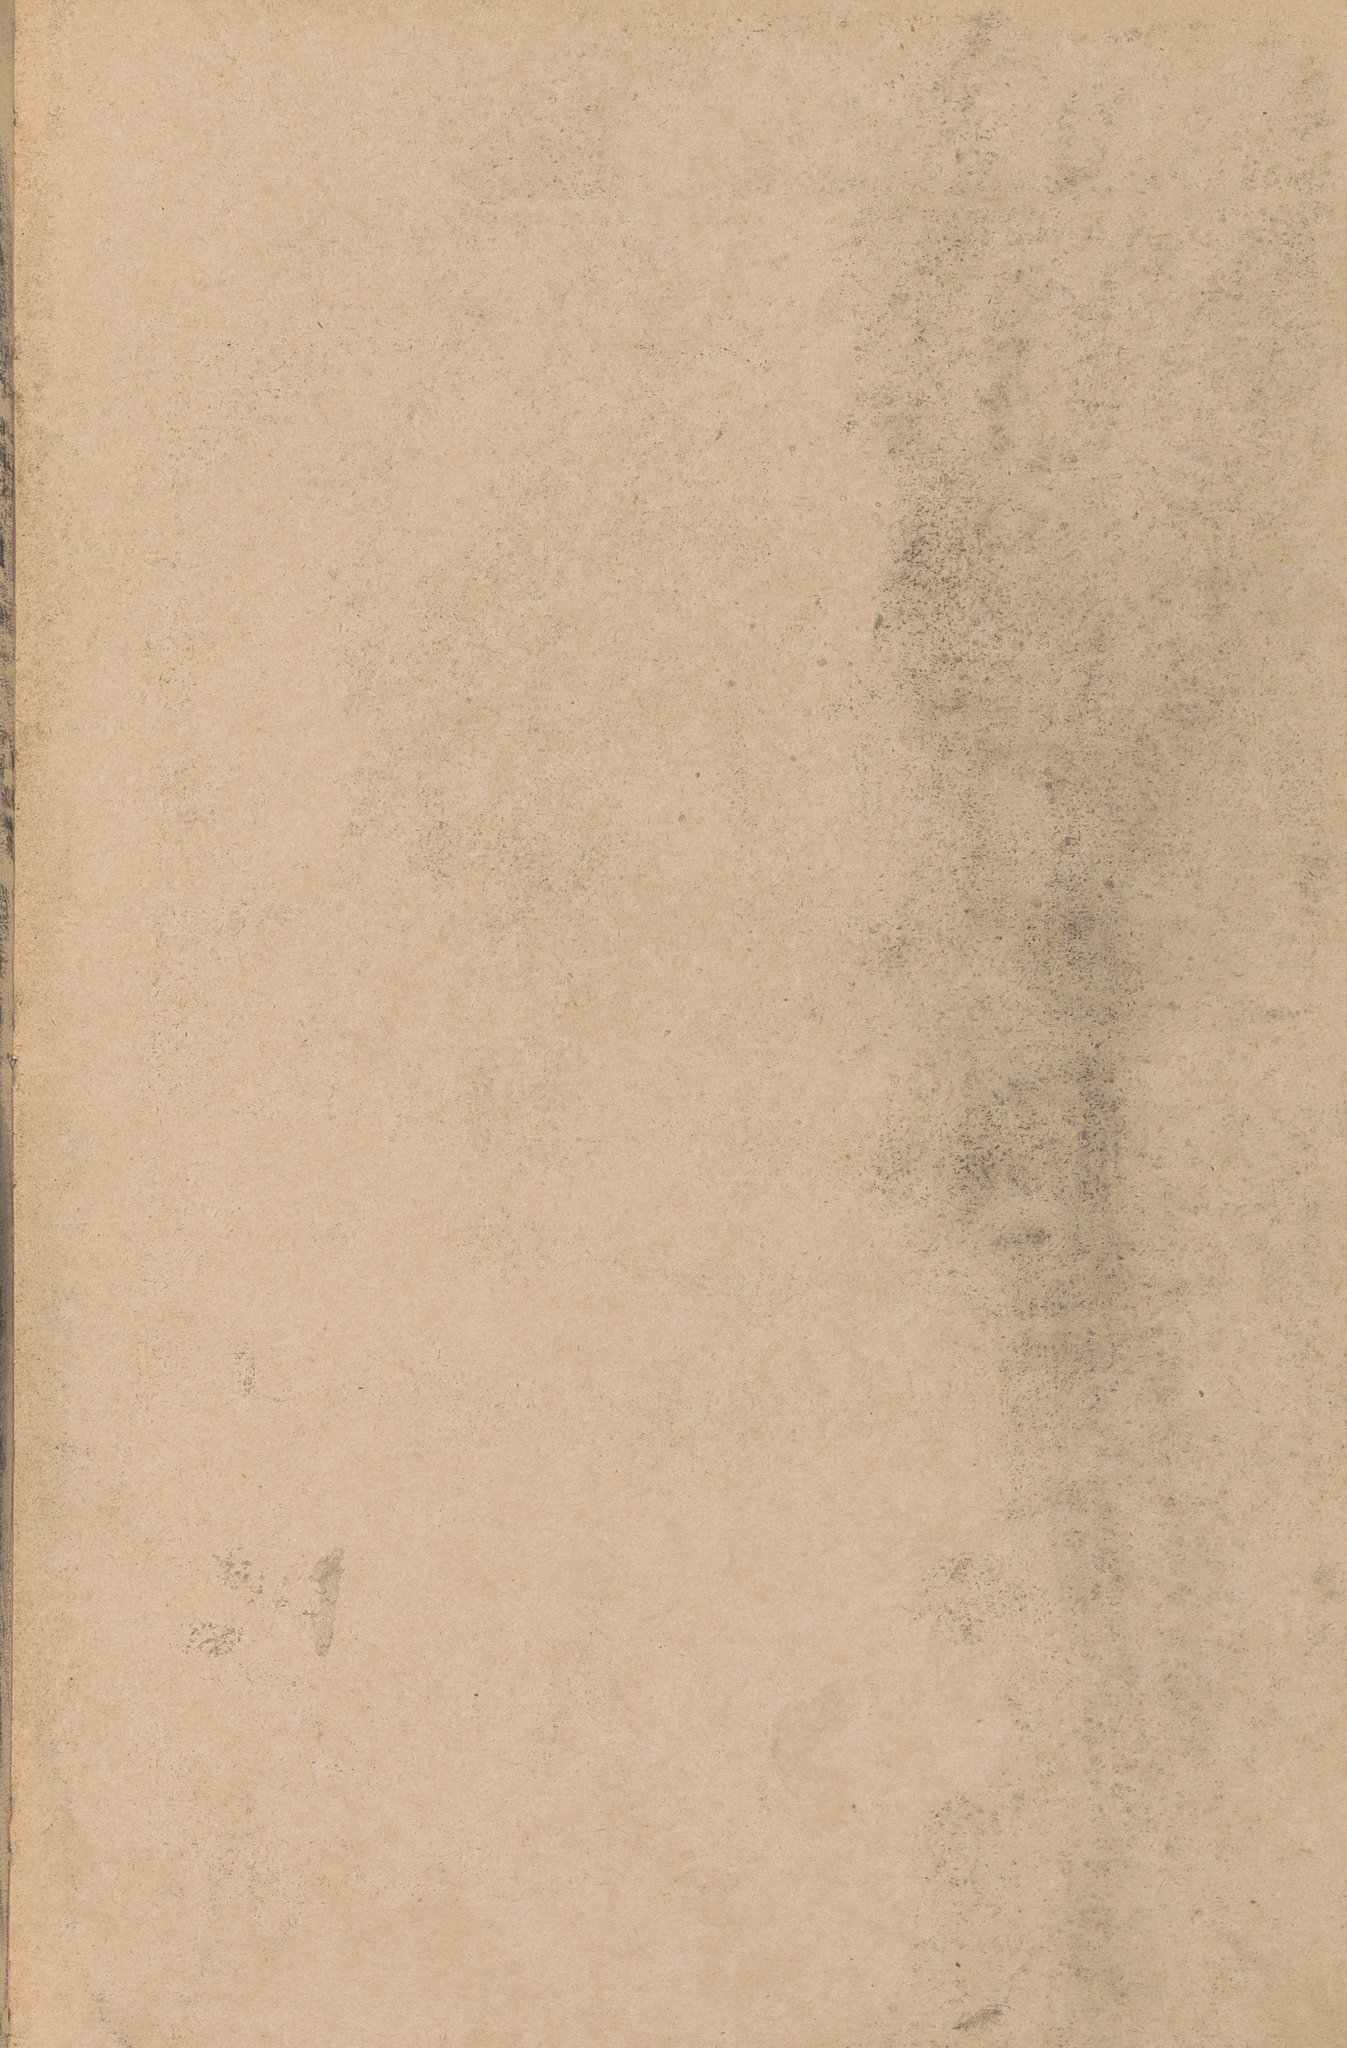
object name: sketchbook leaf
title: Abklatsch van de krijttekening op pagina 16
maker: willem witsen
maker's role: draughtsman, painter, print maker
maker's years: 1860-1923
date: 1884-1887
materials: paper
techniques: printmaking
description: Pagina 17 uit een schetsboek met 38 bladen.